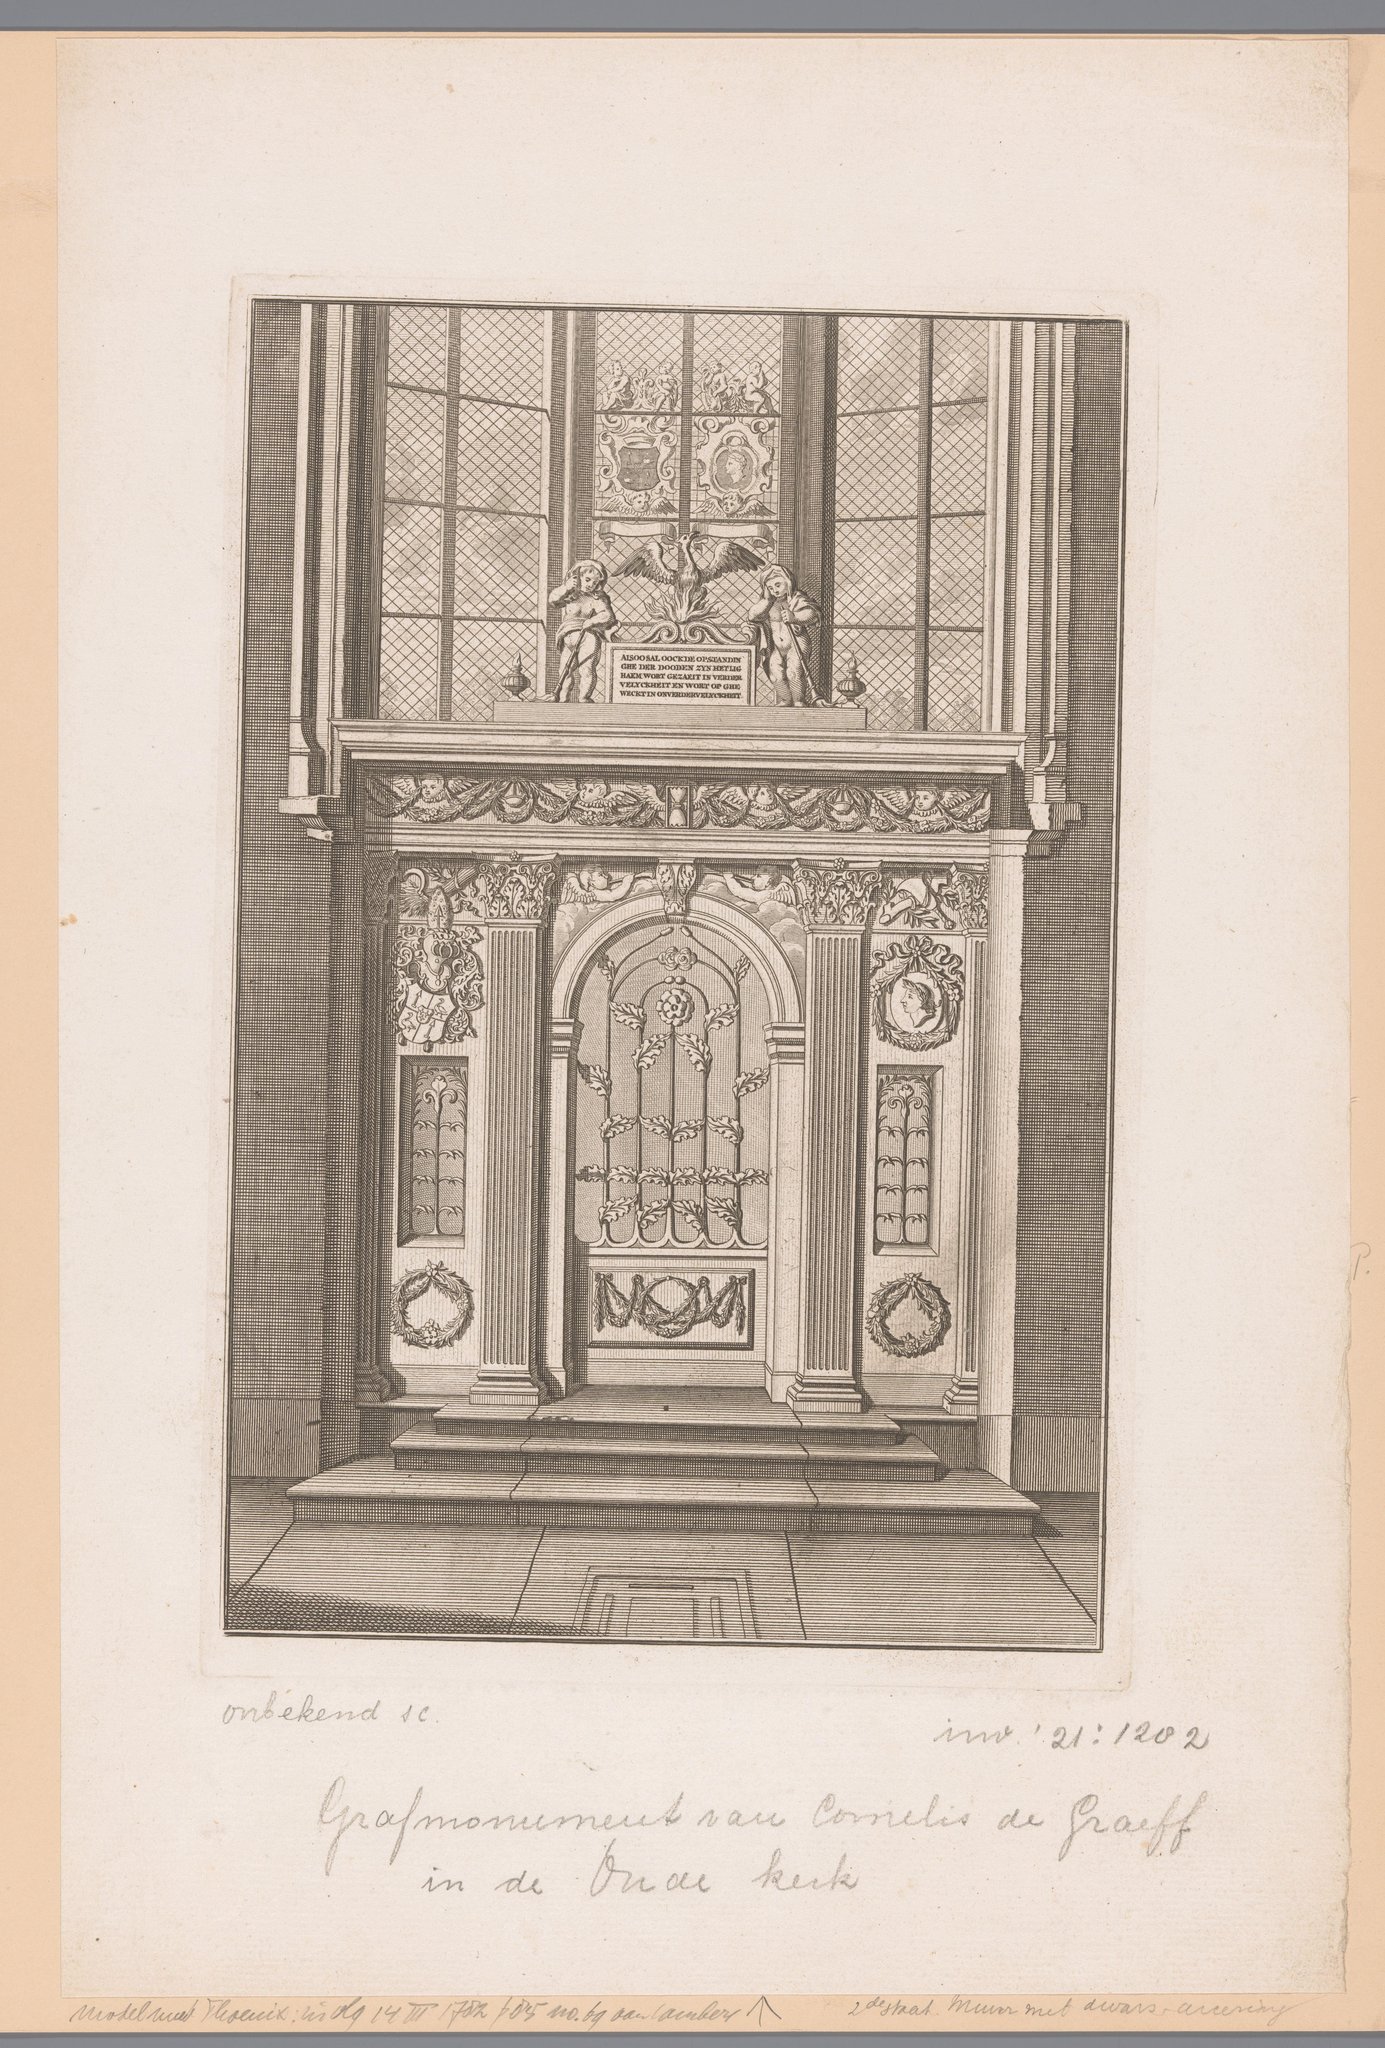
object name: book illustration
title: Grafmonument voor Cornelis de Graeff in de Oude Kerk te Amsterdam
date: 1726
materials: paper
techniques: engraving, etching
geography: amsterdam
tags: amsterdam, mayor, cornelis de graeff, parts of church interior, grave-building, monumental tomb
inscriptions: collector's mark: Lugt 2233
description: Prent uit: Commelin, Caspar. Beschryvinge van Amsterdam, zynde een naukeurige verhandelinge van desselfs eerste oorspronk uyt (…). Amsterdam: Andries van Damme et al., 1726, tussen p. 436 en 437. Eerdere staat gebruikt in: Commelin, Caspar. Beschryvinge van Amsterdam, desselfs eerste oorspronk uyt den Huyse (…). Amsterdam: Abraham Wolfgang et al.., 1693. En in: Commelin, Caspar. Beschryvinge van Amsterdam, zynde een naukeurige verhandelinge van desselfs eerste oorspronk uyt (…). Amsterdam: weduwe Aart Dircksz Oossaan, 1694.